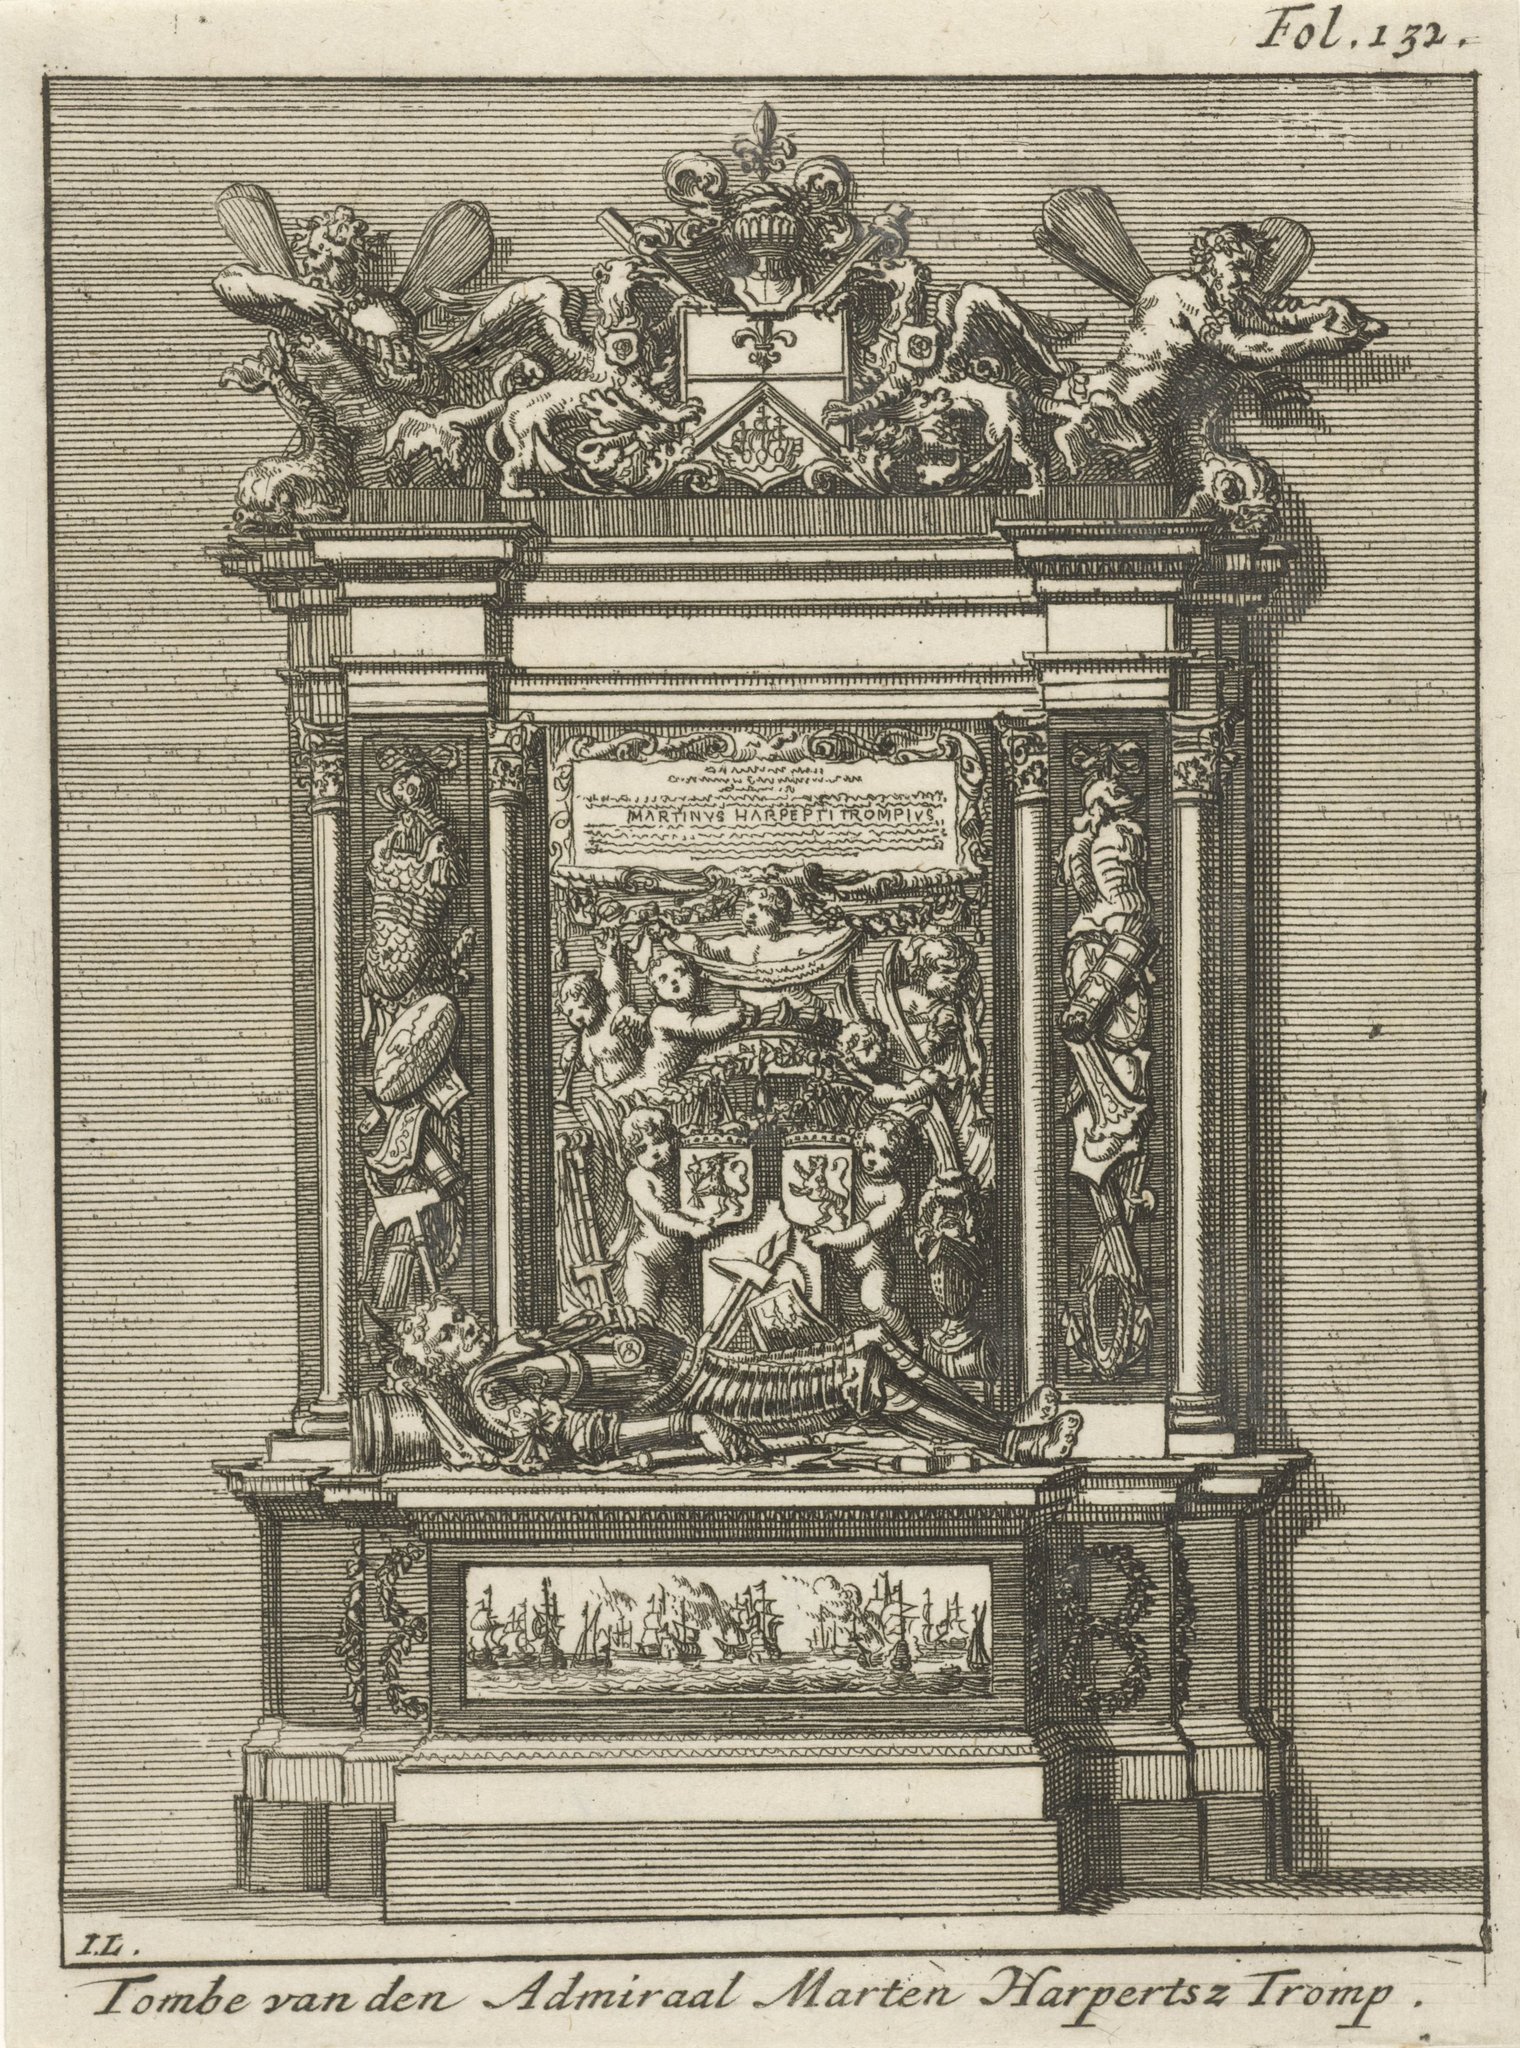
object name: book illustration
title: Tombe van de Admiraal Marten Harpertsz Tromp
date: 1692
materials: paper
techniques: etching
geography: haarlem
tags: brielle, maarten harpertszoon tromp, grave, tomb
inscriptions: collector's mark: Lugt 2228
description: Illustratie uit: Leven en bedryf van den vermaarden zeeheld Cornelis Tromp. Amsterdam: Timotheus ten Hoorn; Haarlem: Jacob Albertsz van Beverwĳk, 1692.